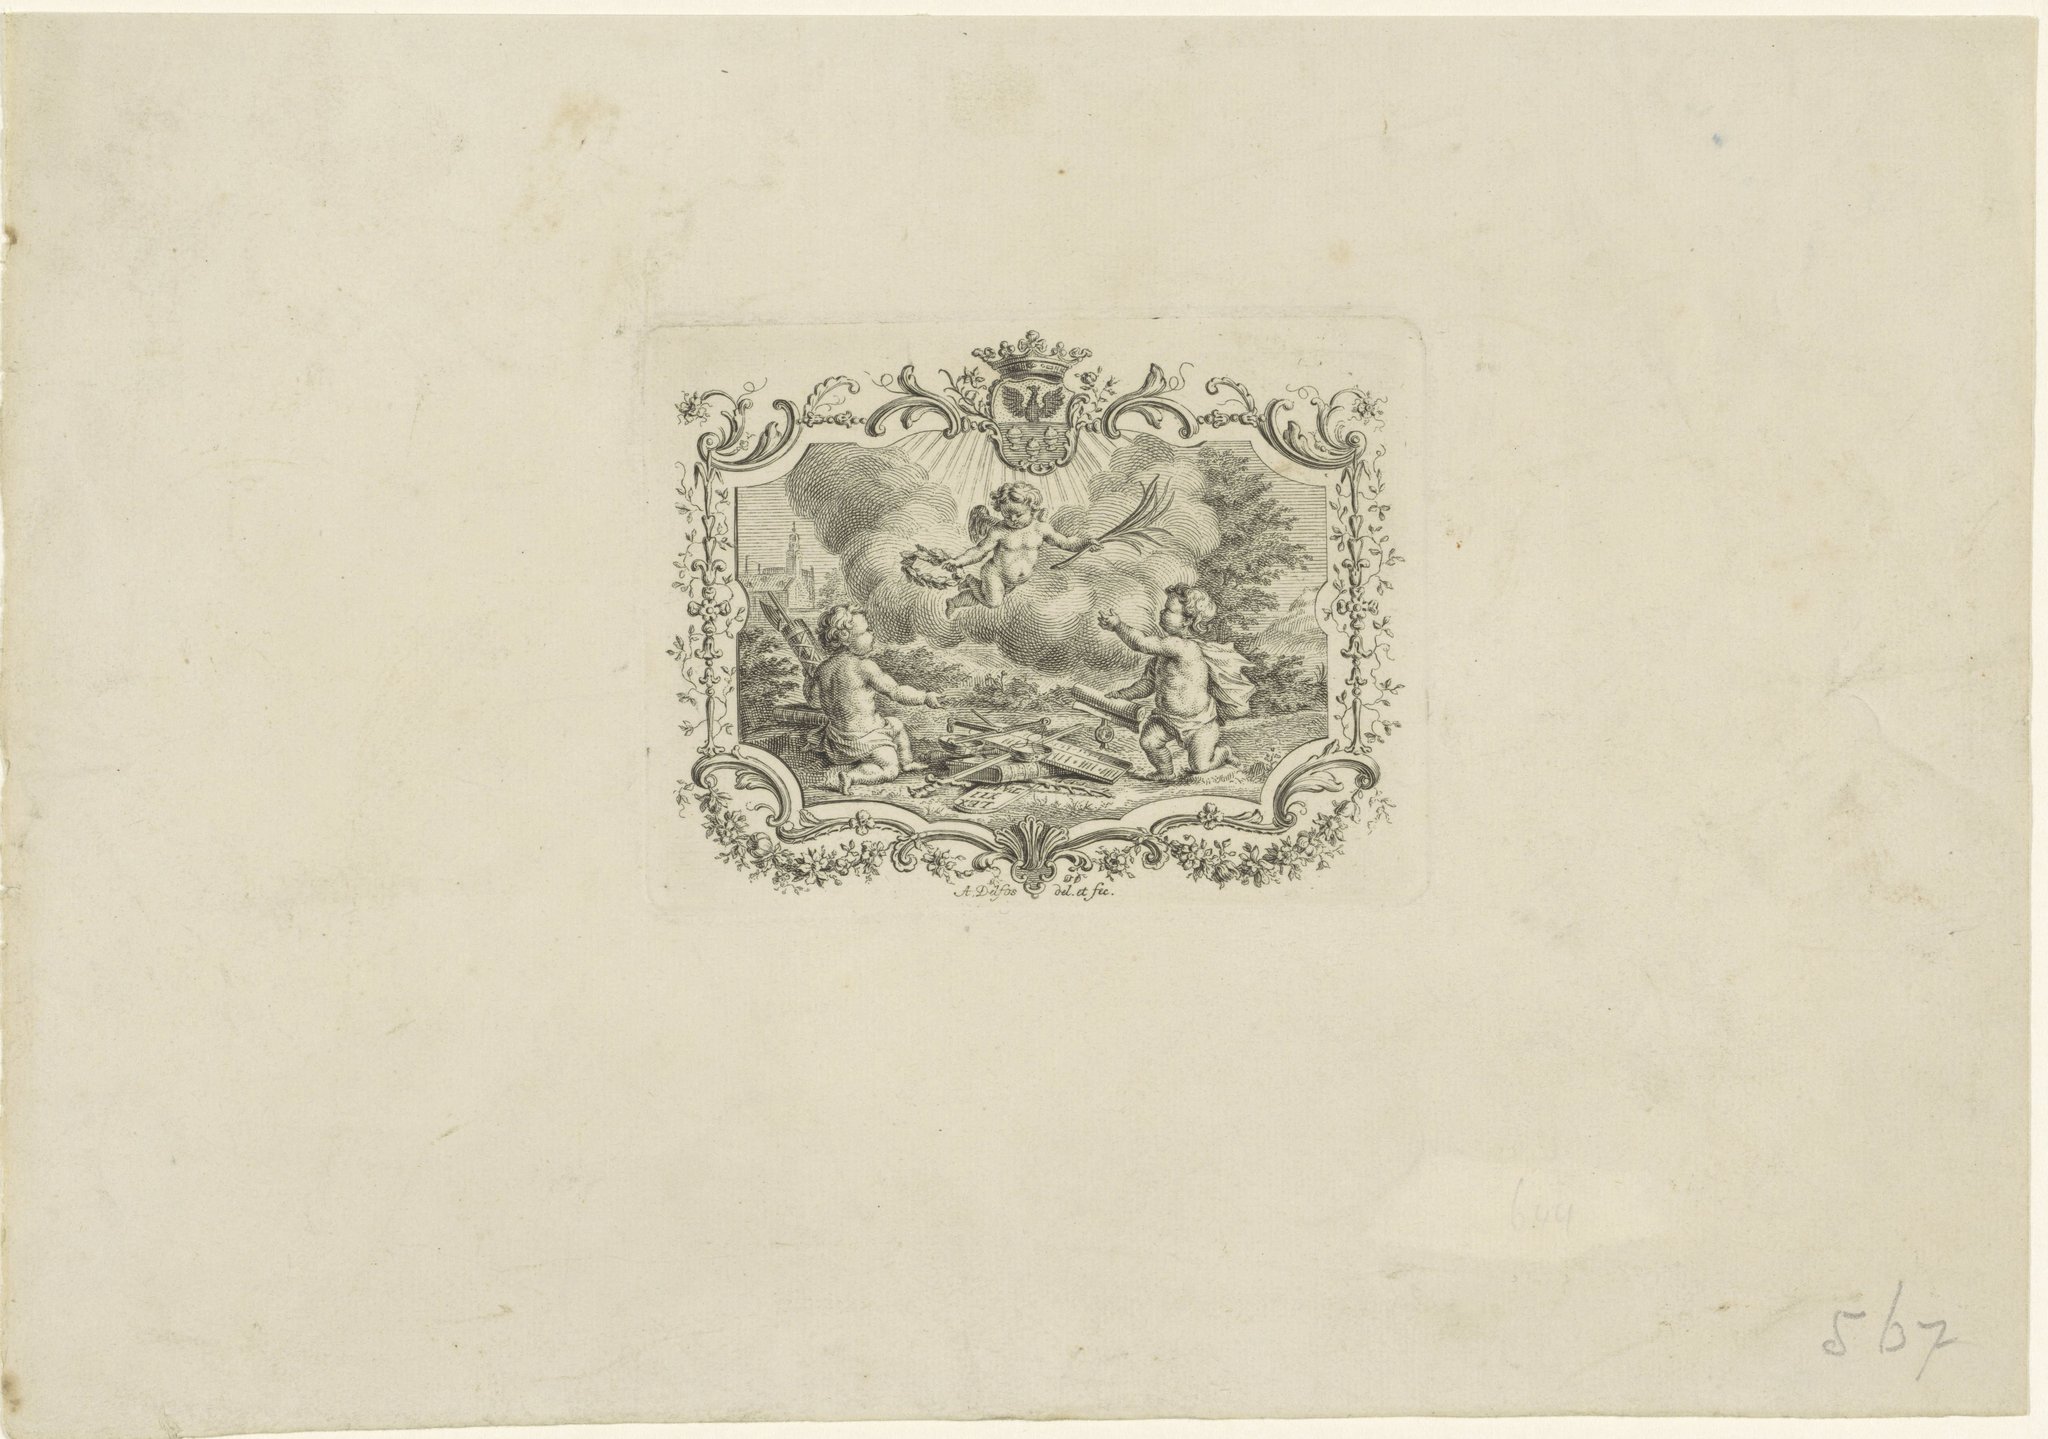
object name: ornament print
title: Allegorie op vrede met drie putti in cartouche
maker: abraham delfos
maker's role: draughtsman, painter, print maker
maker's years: 1731-1820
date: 1741-1820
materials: paper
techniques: etching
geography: leiden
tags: symbols, allegories of peace, 'pax'; 'pace' (ripa), cupids: 'amores', 'amoretti', 'putti'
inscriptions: collector's mark: Lugt 2760, collector's mark: Lugt 2228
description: Allegorie op vrede met drie putti in landschap in cartouche met midden boven een wapenschild. Een puto haoudt een fasces in de hand. In het midden vliegt een putto met lauwerkrans en palmtak.